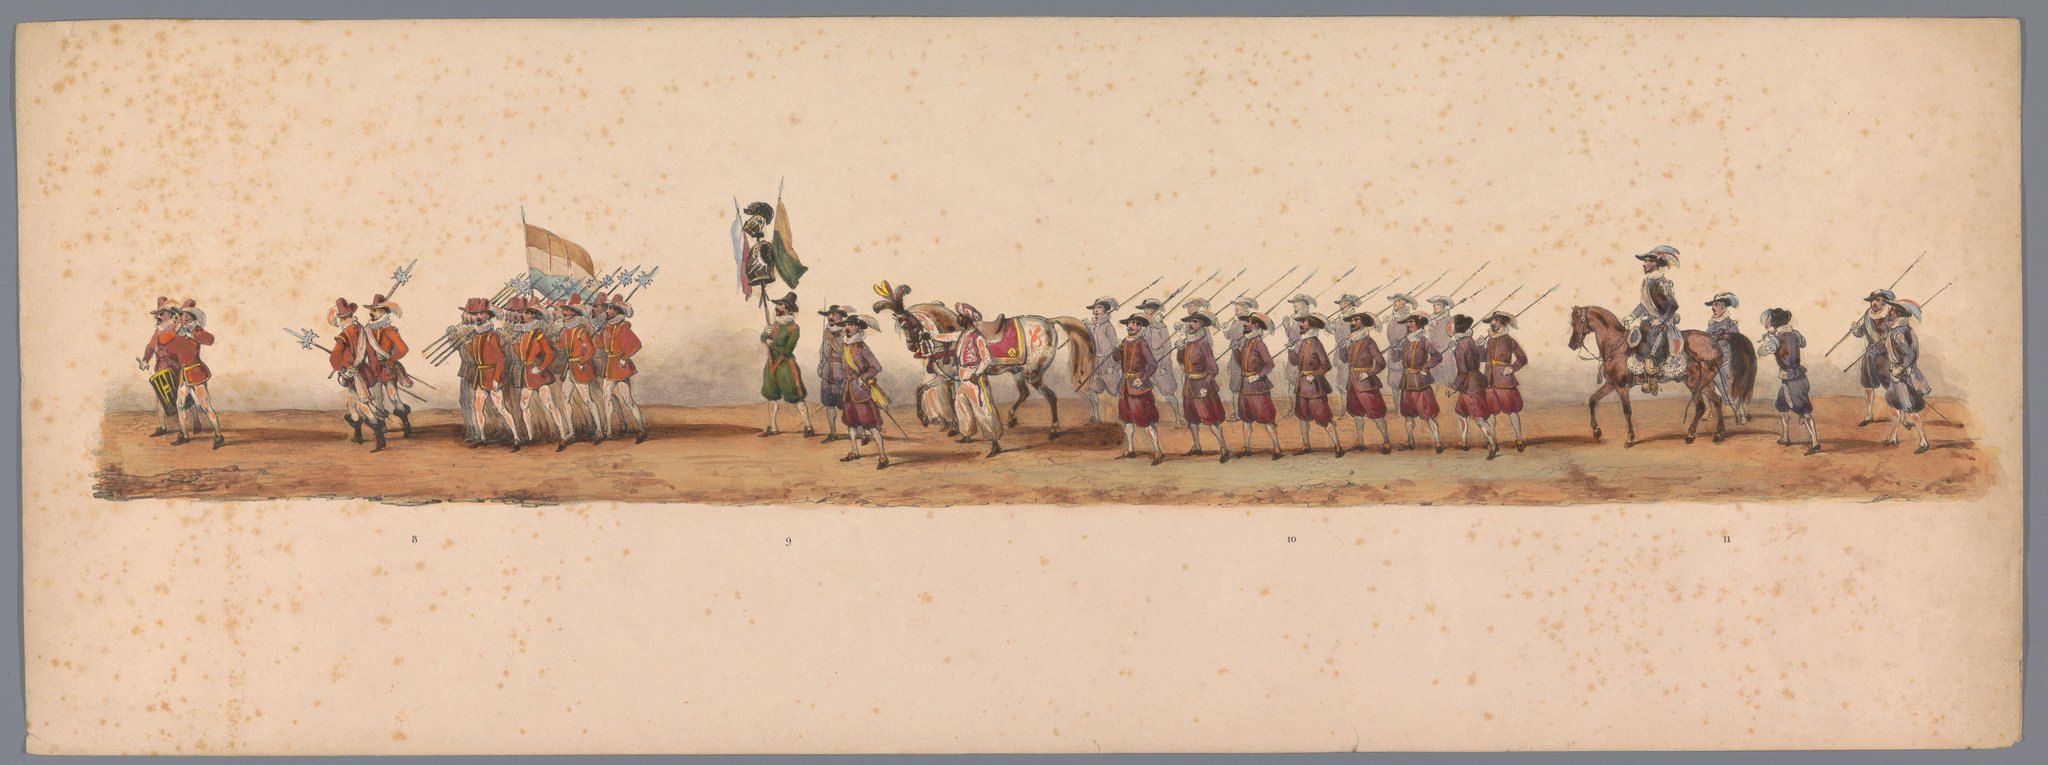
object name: print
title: Optogt des Nederlandschen Legers naar Ostende, den 3 July 1600, daags na de overwinning by Nieuwpoort; volgens de gecostumeerde voorstelling, gegeven door H H Studenten, by gelegenheid van het Tweede Eeuwfeest der Utrechtsche Hoogeschool. den 16 Juny 1836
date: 1837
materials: paper, watercolor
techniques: hand coloring, lithograph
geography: rotterdam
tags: students' pageant, costumes used in pageants, battle of nieuwpoort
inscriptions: date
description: Historische gekostumeerde optocht van de studenten van de Hogeschool van Utrecht op 16 juni 1836, bij de viering van het tweede eeuwfeest van de Utrechtse Hogeschool. De optocht verbeeldt de intocht van het Staatse leger in Oostende op 3 juli 1600, daags na de overwinning in de Slag bij Nieuwpoort. Derde plaat in een serie van tien ongenummerde platen, met de groepen genummerd 8-11.